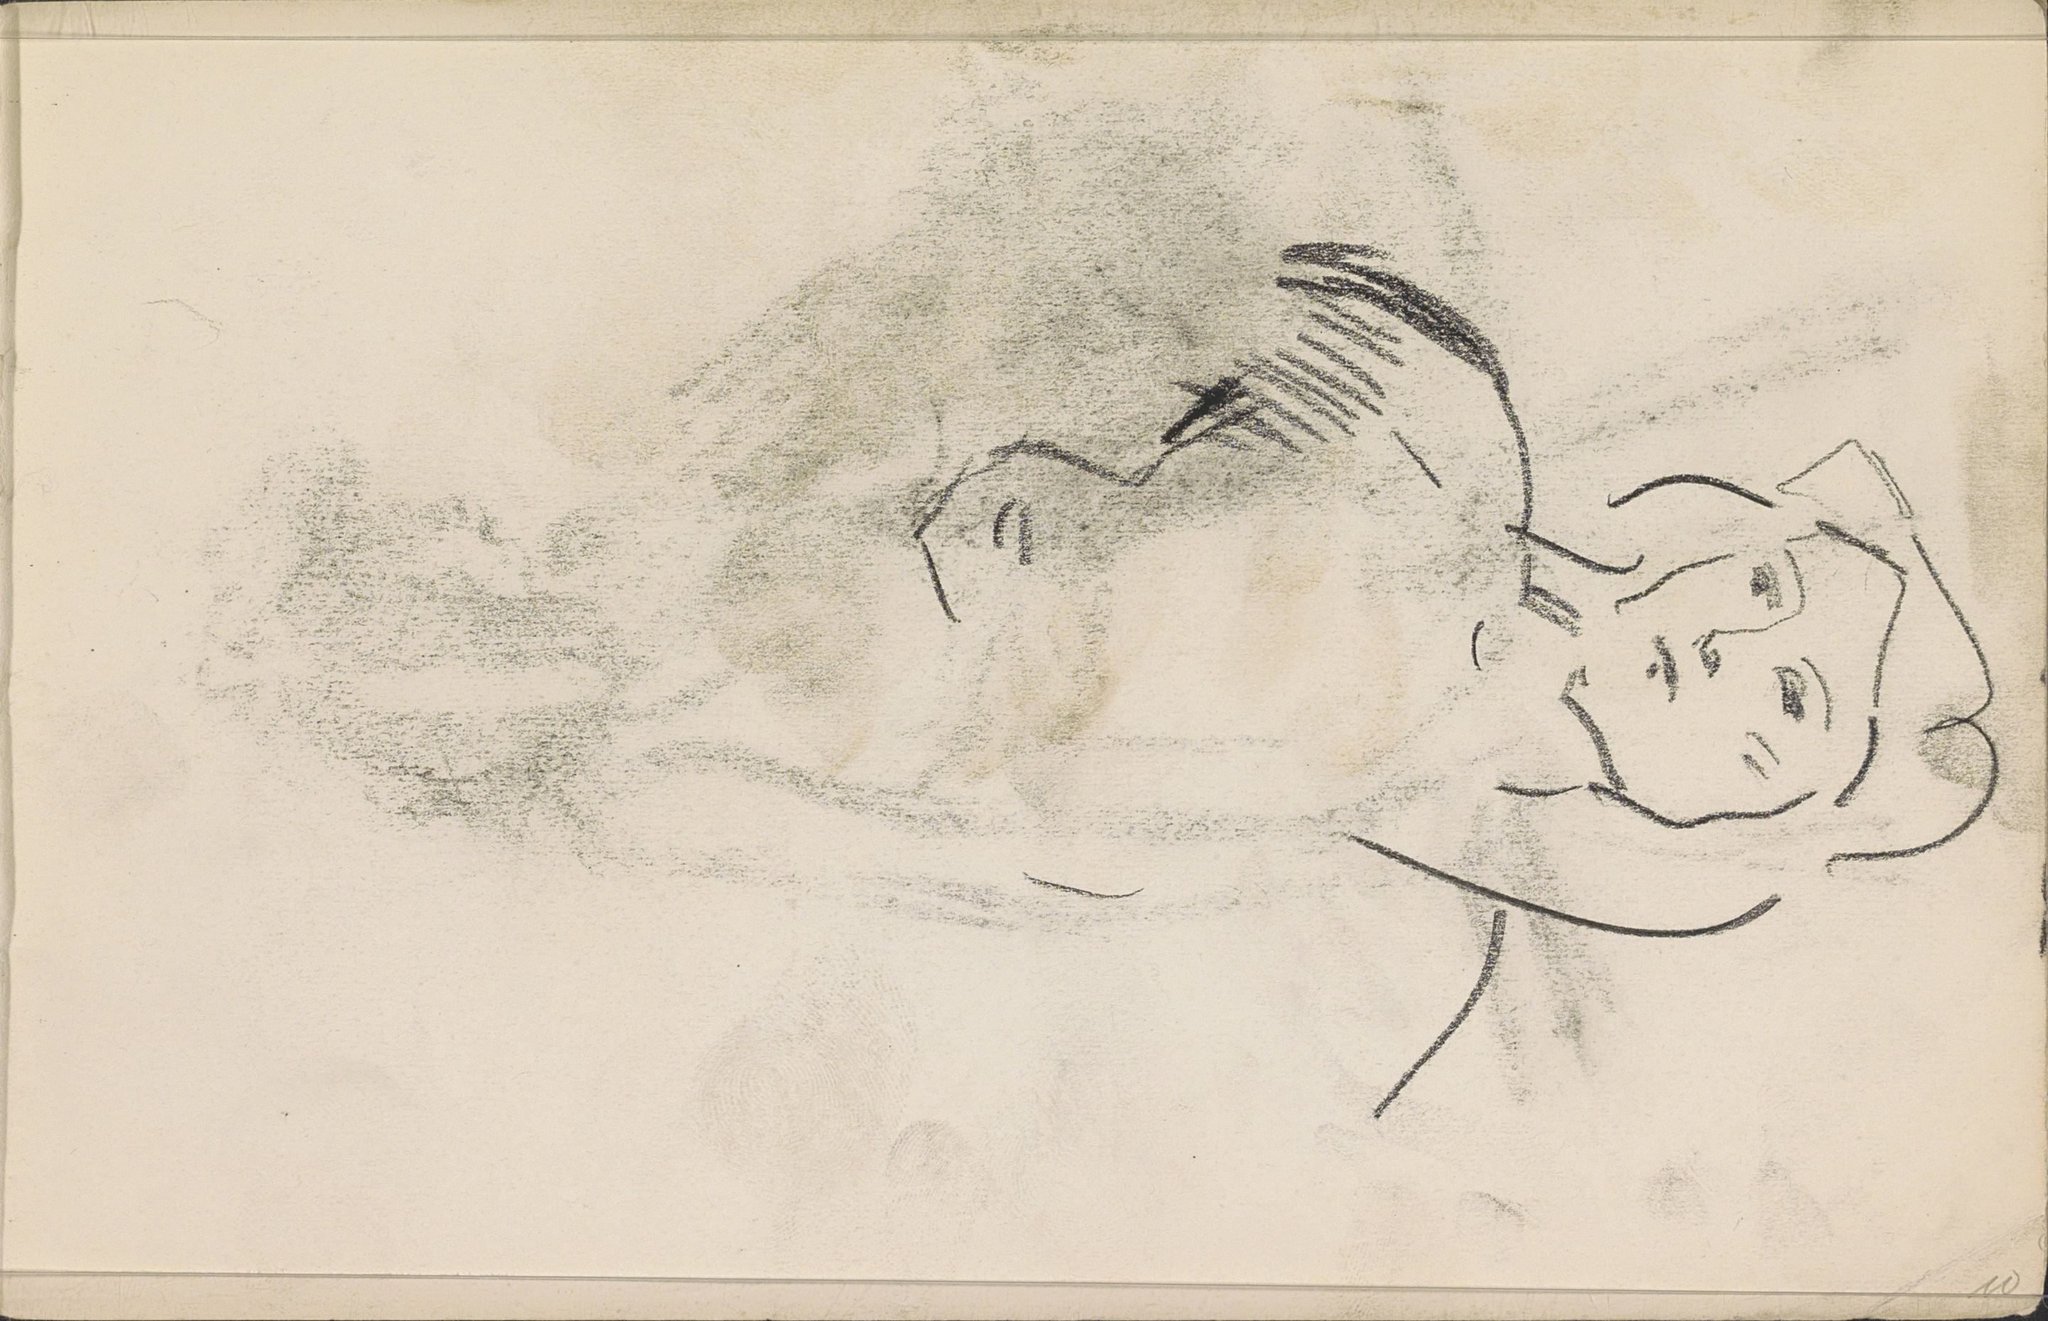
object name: sketchbook leaf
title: Vrouwelijk naakt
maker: isaac israels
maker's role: draughtsman, painter, print maker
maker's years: 1865-1934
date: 1875-1934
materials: chalk, paper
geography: paris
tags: the (nude) human figure; 'corpo humano' (ripa) - aa - female human figure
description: Blad 10 recto uit schetsboek LI met 11 bladen.